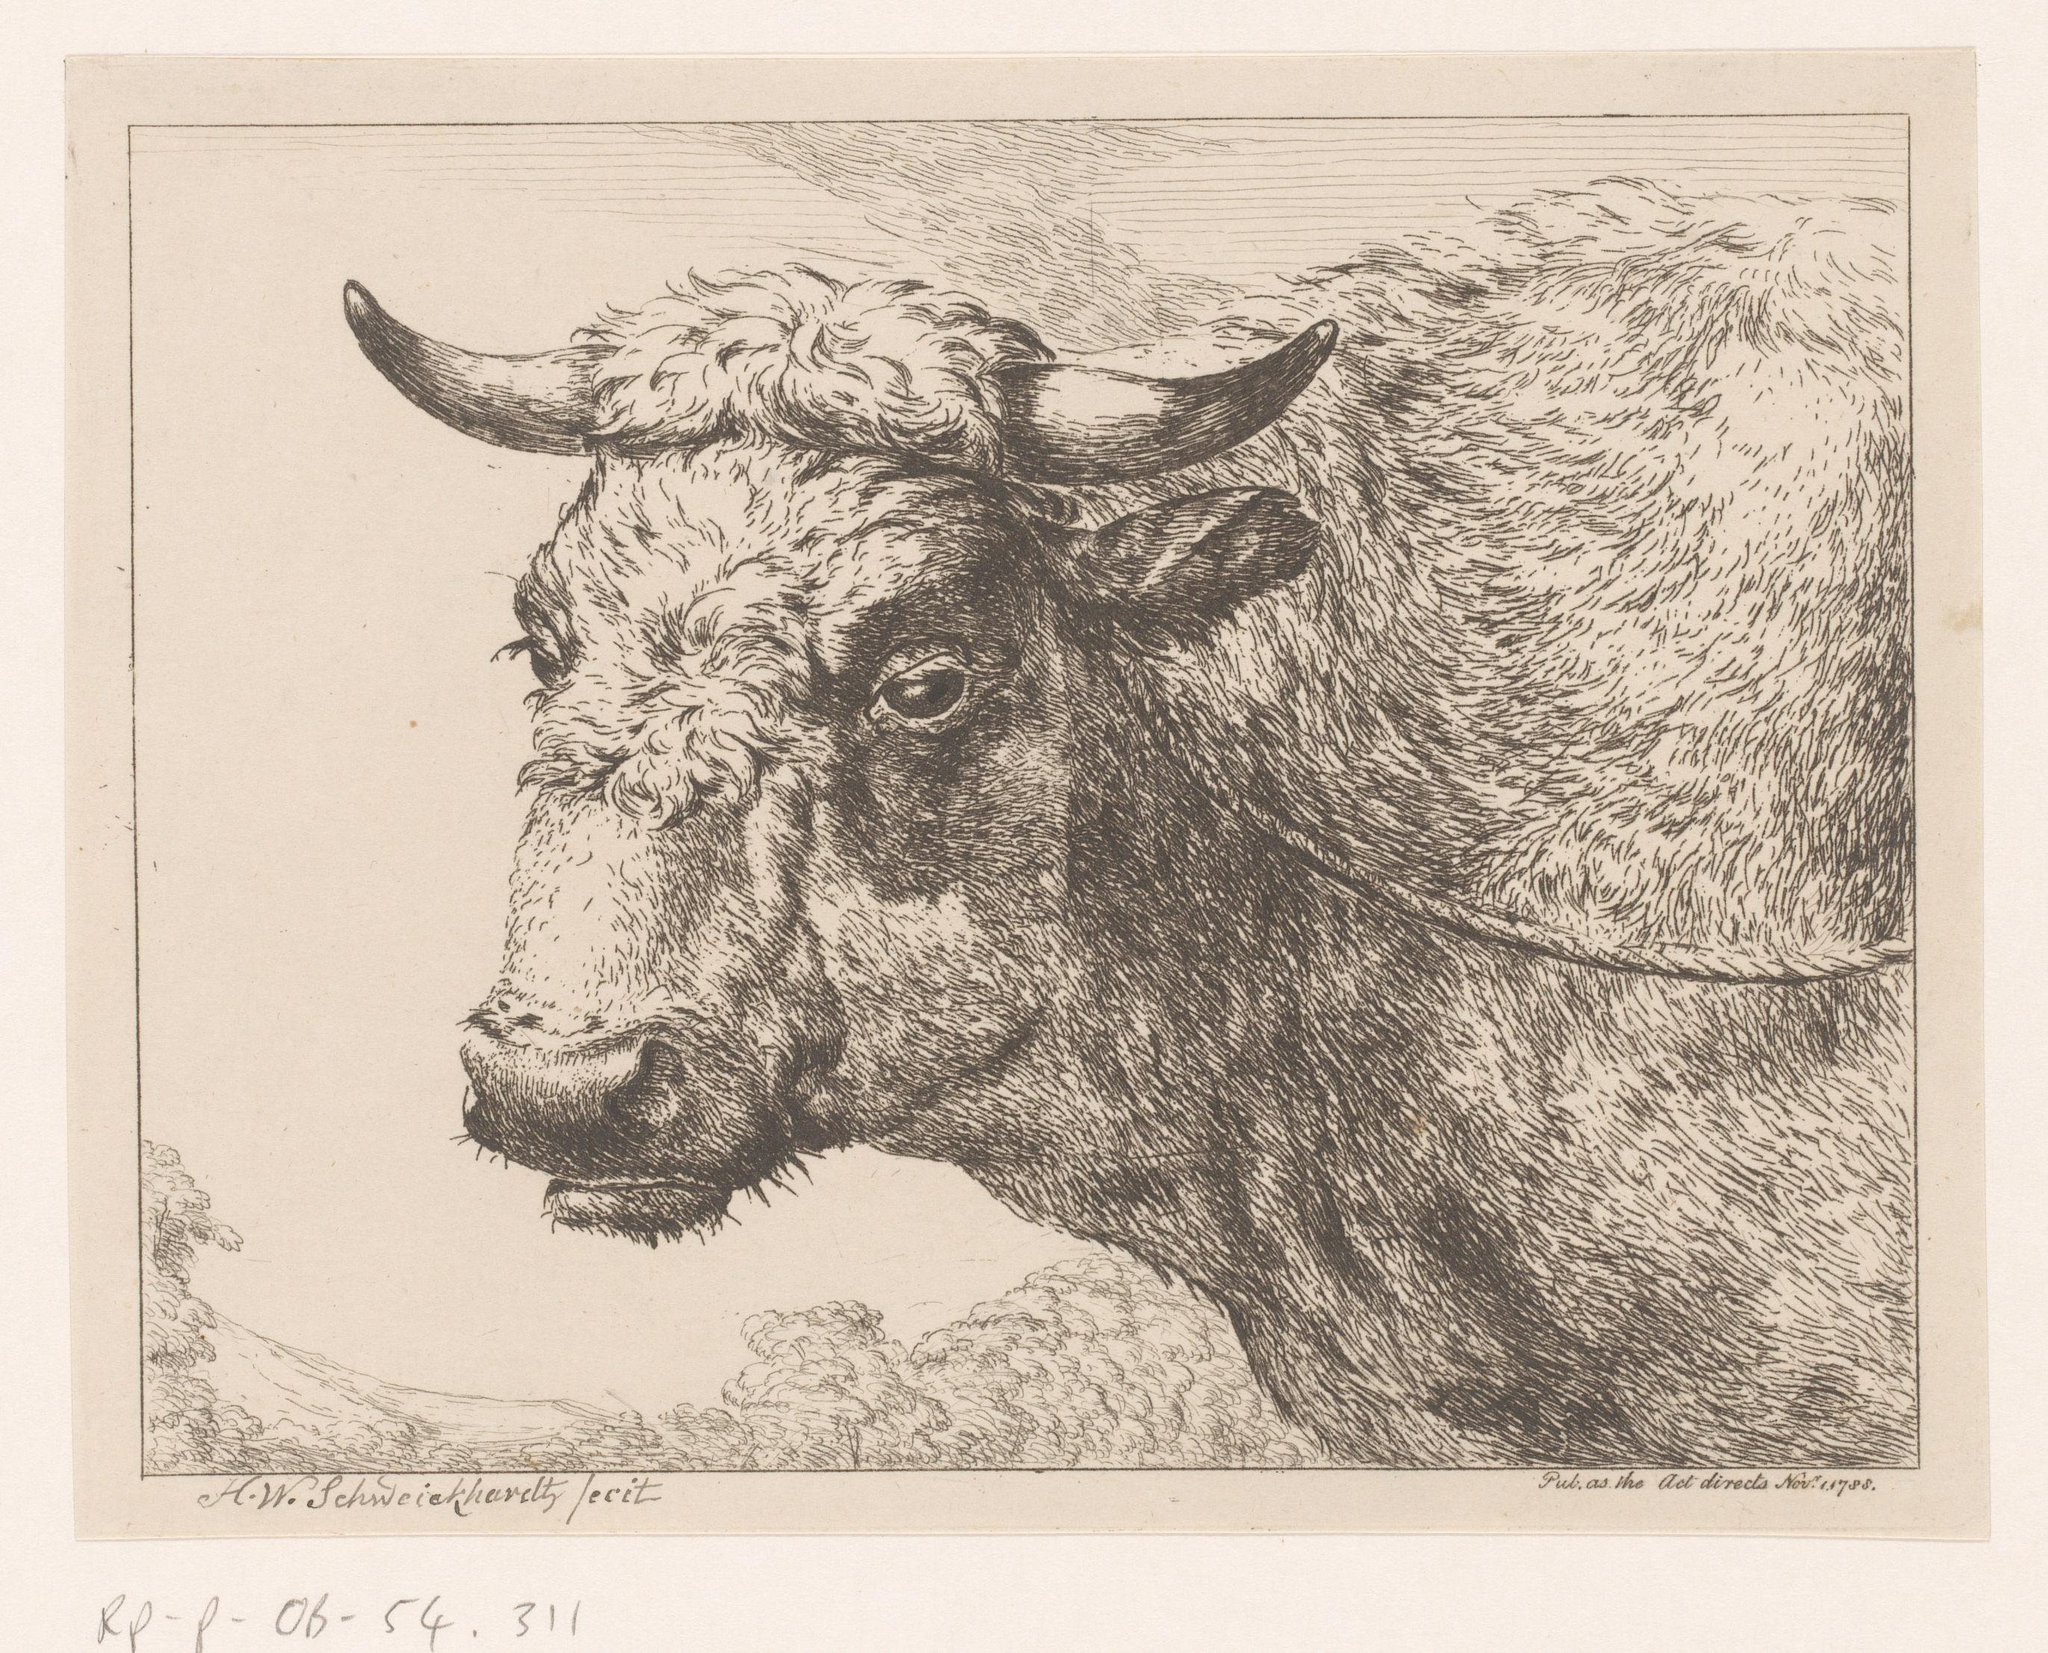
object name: print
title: Kop van een koe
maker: hendrik willem schweickhardt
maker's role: draughtsman, painter, print maker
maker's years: 1746-1797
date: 1788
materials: paper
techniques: etching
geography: england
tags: cow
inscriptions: collector's mark: Lugt 1377, collector's mark: Lugt 2228, signature: ‘H.W. Schweickhardt fecit’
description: Behoort tot een serie van twee prenten met koppen van koeien.